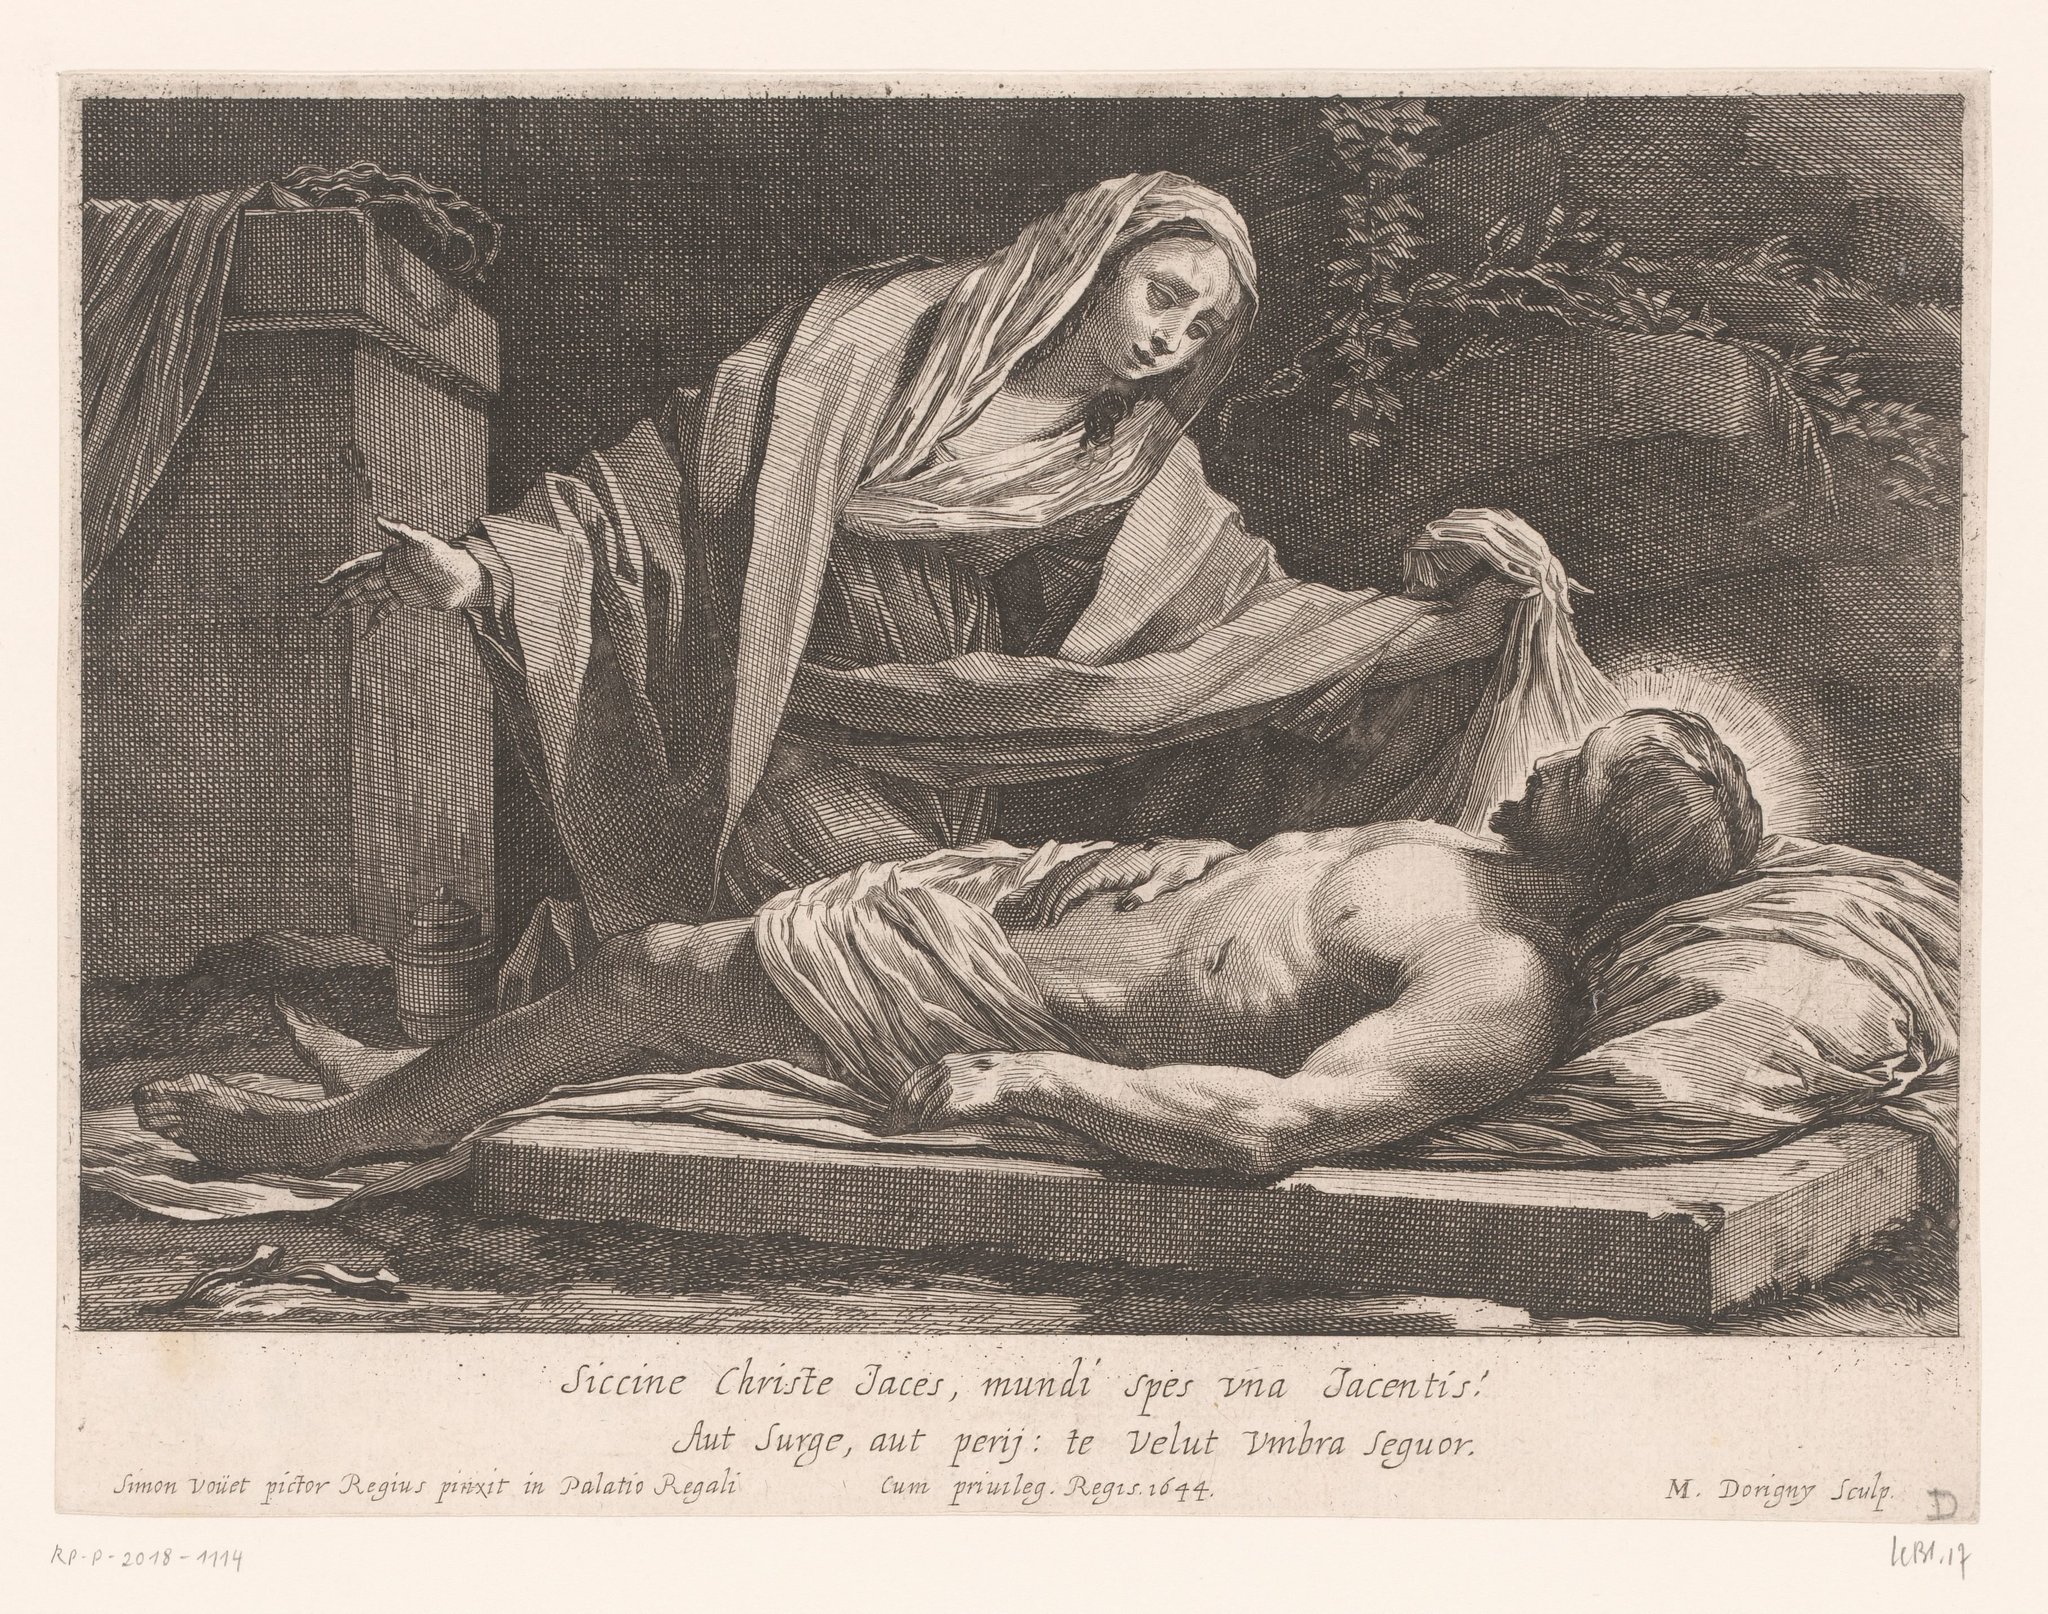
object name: print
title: Bewening van Christus door Maria Magdalena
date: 1644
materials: paper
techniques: engraving, etching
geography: france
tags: lamentation over the dead christ by his relatives and friends (christ usually without crown of thorns)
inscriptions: collector's mark: Lugt 2228